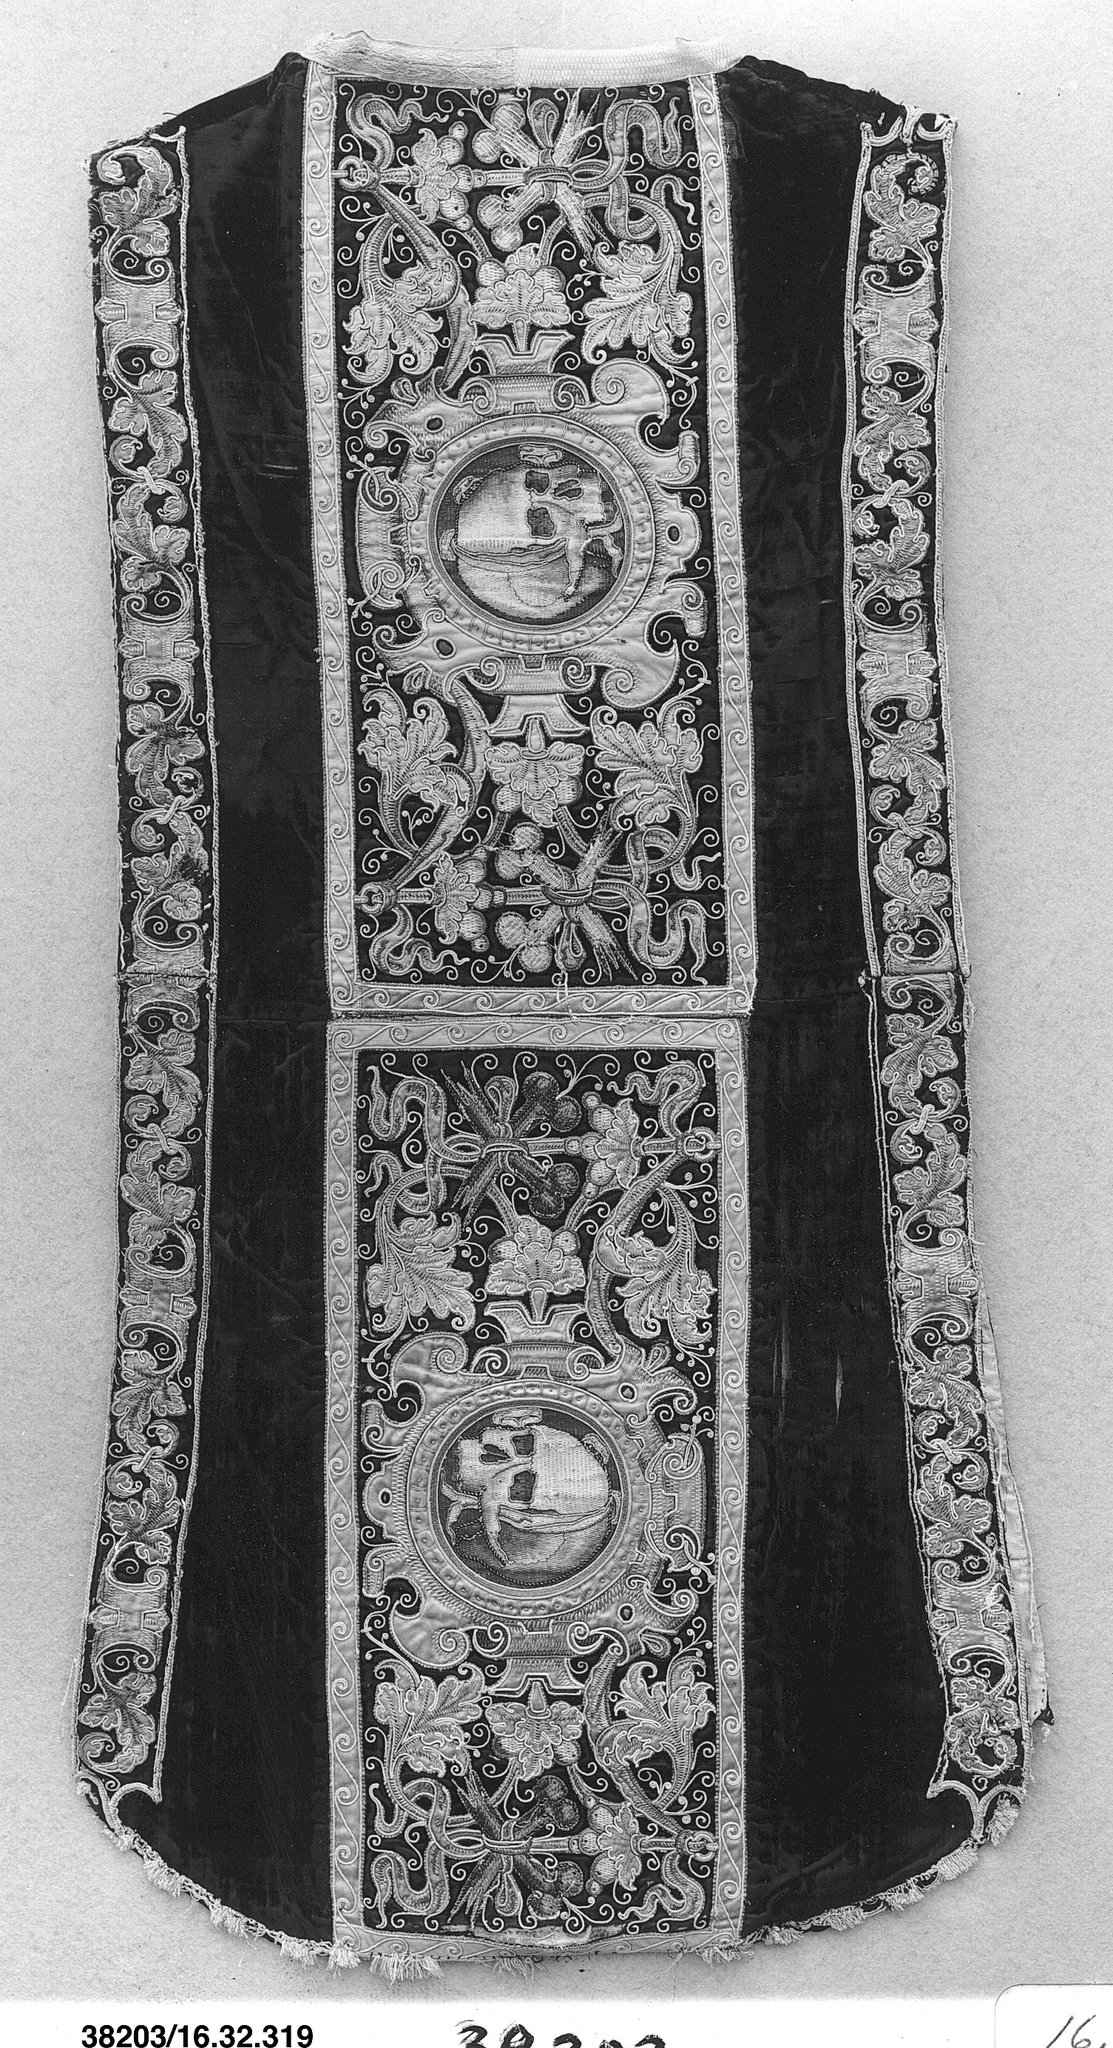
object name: dalmatic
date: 1501-1600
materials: metal thread, silk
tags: skulls,leaves